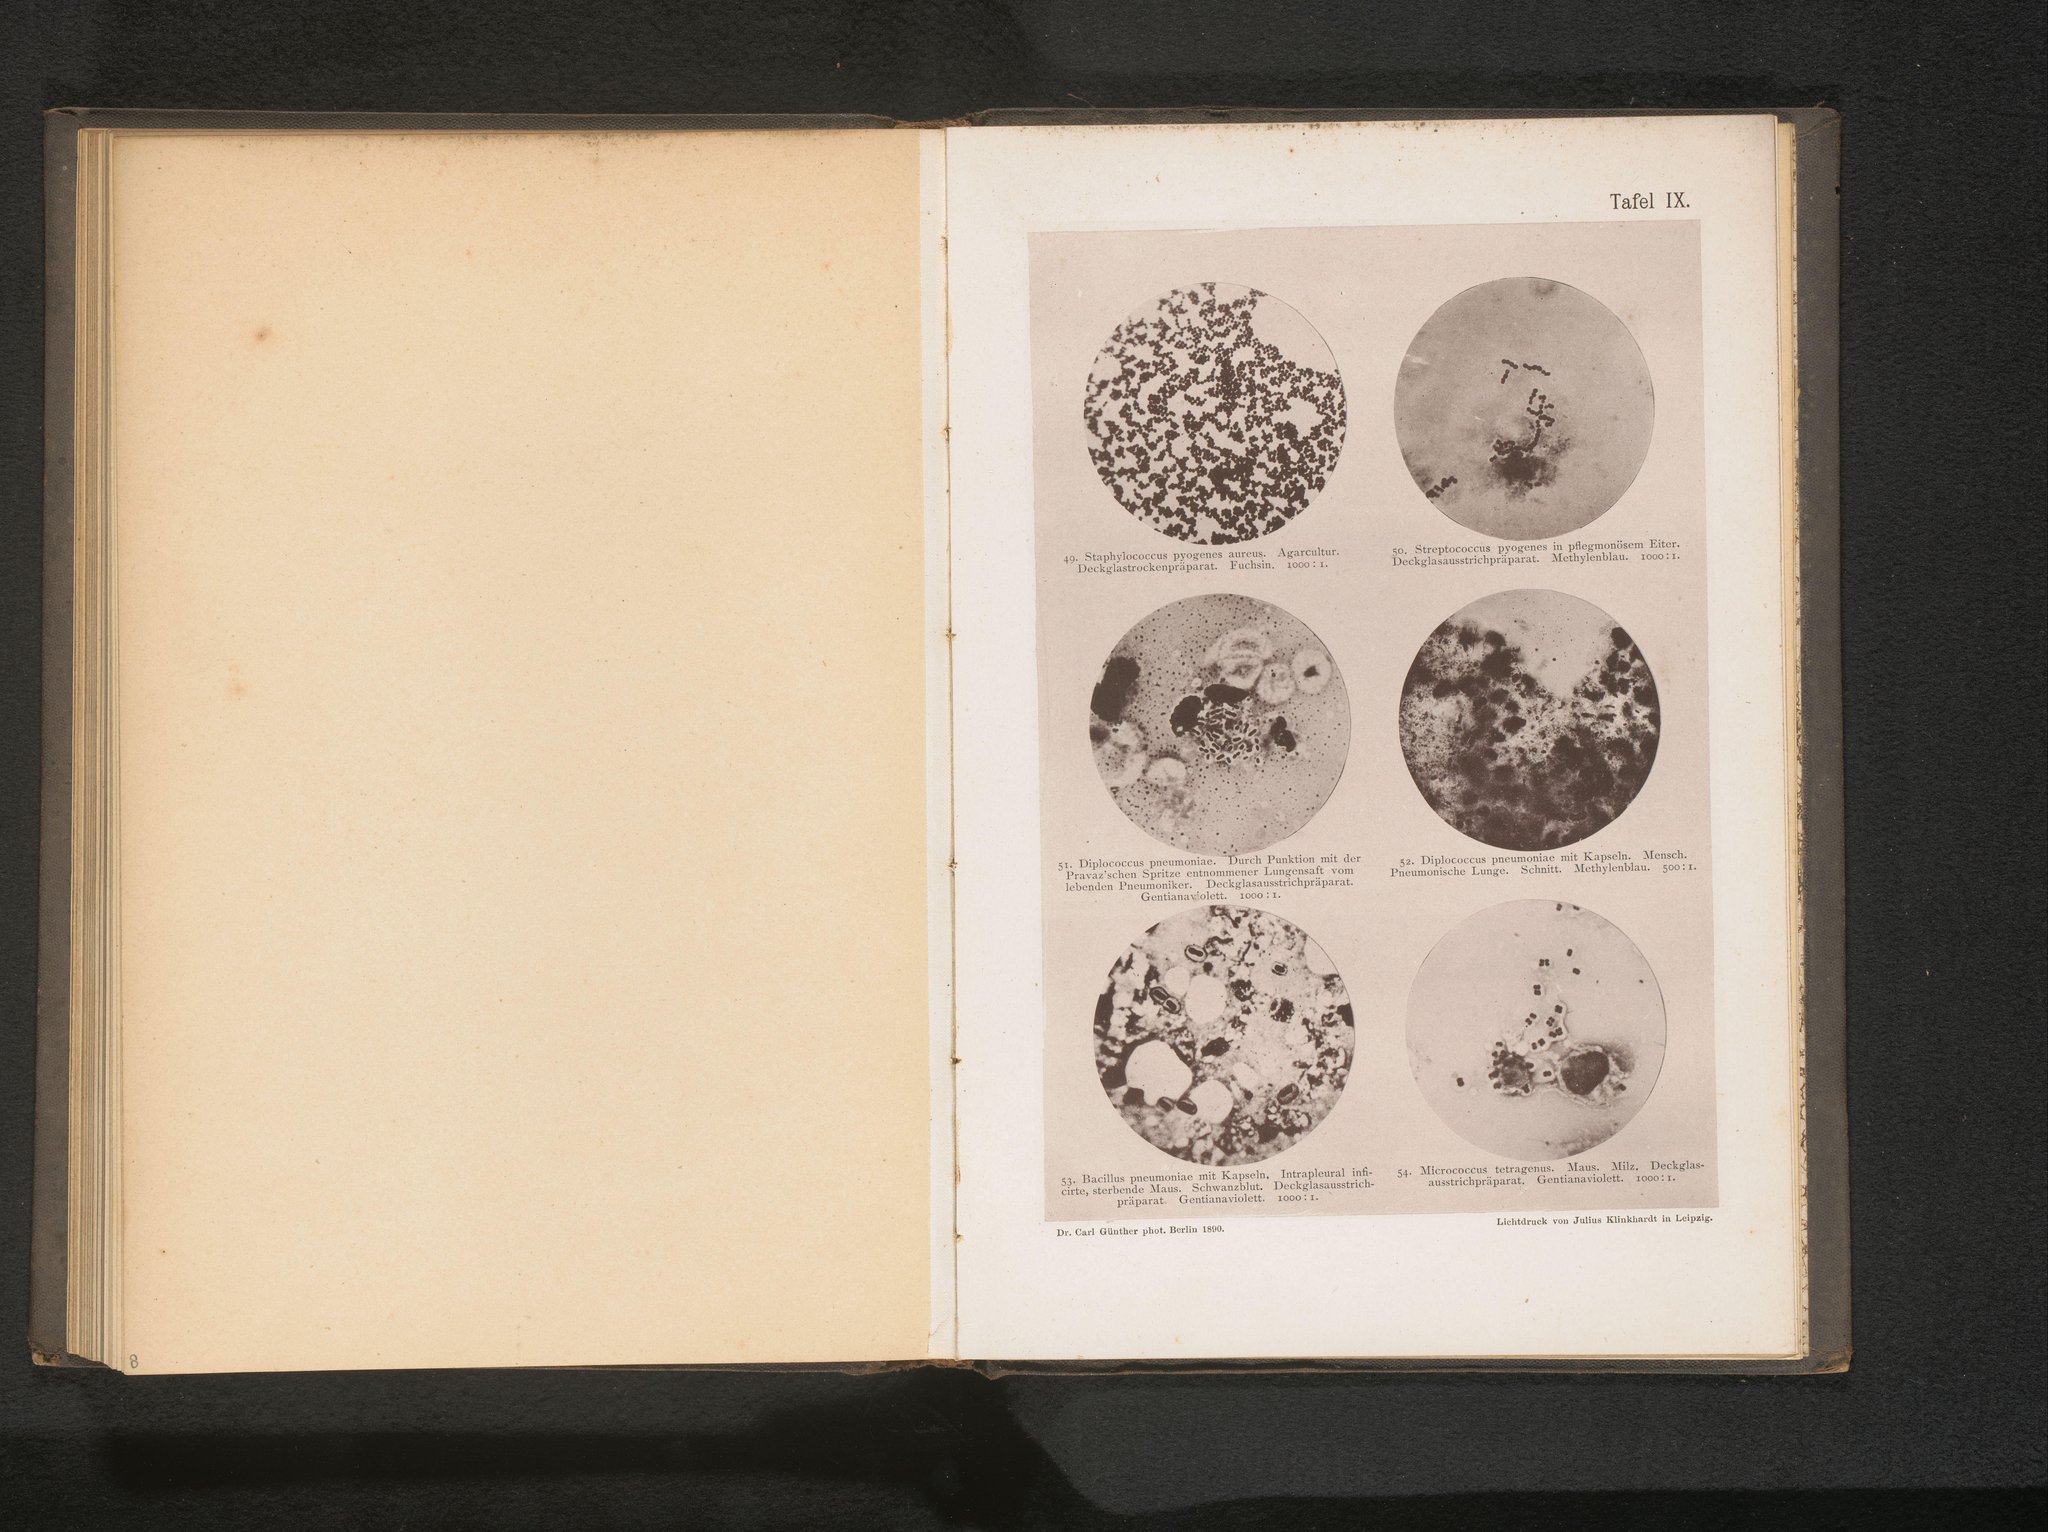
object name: page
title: Zes microscoopopnamen van bacteriën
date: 1880-1890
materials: paper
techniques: photograph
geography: berlin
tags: unicellular animals, bacteria, bacilli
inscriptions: inscription: ‘49. Staphylococcus pyogenes aureus. Agarcultur. Deckglastrockenpräparat. Fuchsin. 1000:1. 50. Streptococcus pyogenes in pflegmonösem Eiter. Deckglasausstrichpräparat. Methylenblau. 1000:1. 51. Diplococcus pneumoniae. Durch Punktion mit der Pravaz'schen Spritze entnommener Lungnsaft vom lebenden Pneumoniker. Deckglasausstrichpräparat. Gentianaviolett. 1000:1. 52. Diplococcus pleumoniae mit Kapseln. Mensch. Pneumonische Lunge. Schnitt. Methylenblau. 500:1. 53. Bacillus pneumoniae mit Kapseln. Intrapleural inficirte, sterbende Maus. Schwanzblut. Deckglasausstrichpräparat. Gentianaviolett. 1000:1. 54. Micrococcus tetragenus. Maus. Milz. Deckgalsaustrichpräparat. Gentianaviolett. 1000:1.’, number: ‘Tafel IX.’